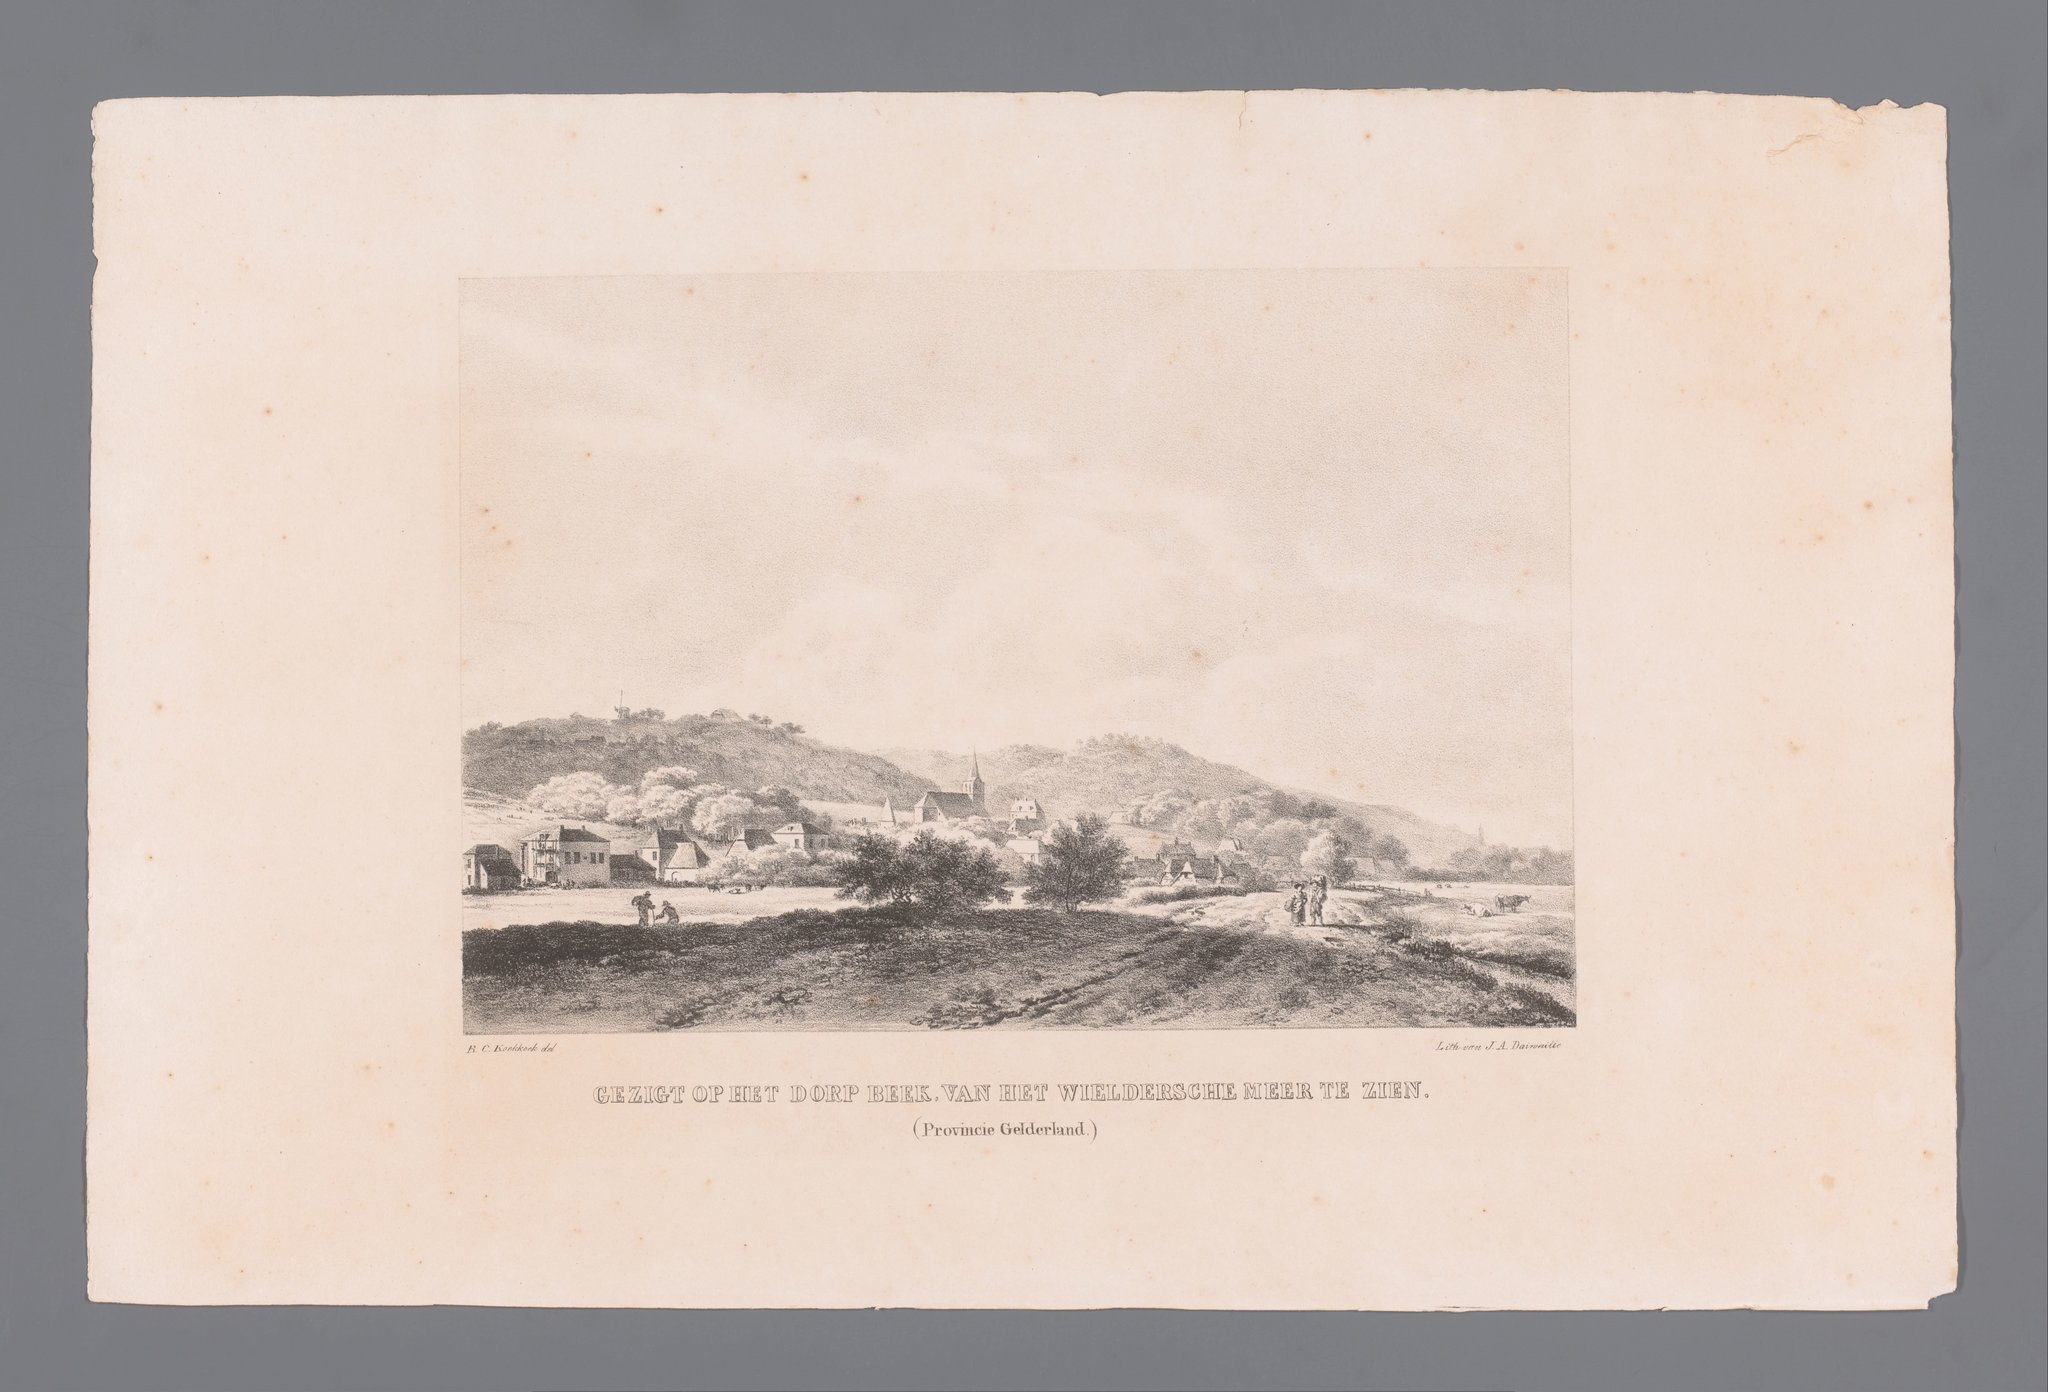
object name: print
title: Vues Pittoresques du Royaume des Pays-Bas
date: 1831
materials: paper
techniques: lithograph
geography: amsterdam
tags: city-view, and landscape with man-made constructions (+ city(-scape) with figures, staffage)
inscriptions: collector's mark: Lugt 12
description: In het weiland koeien en een boerin. Verderop de kerk van Beek. Deze prent maakt deel uit van een omslag met negen prenten.